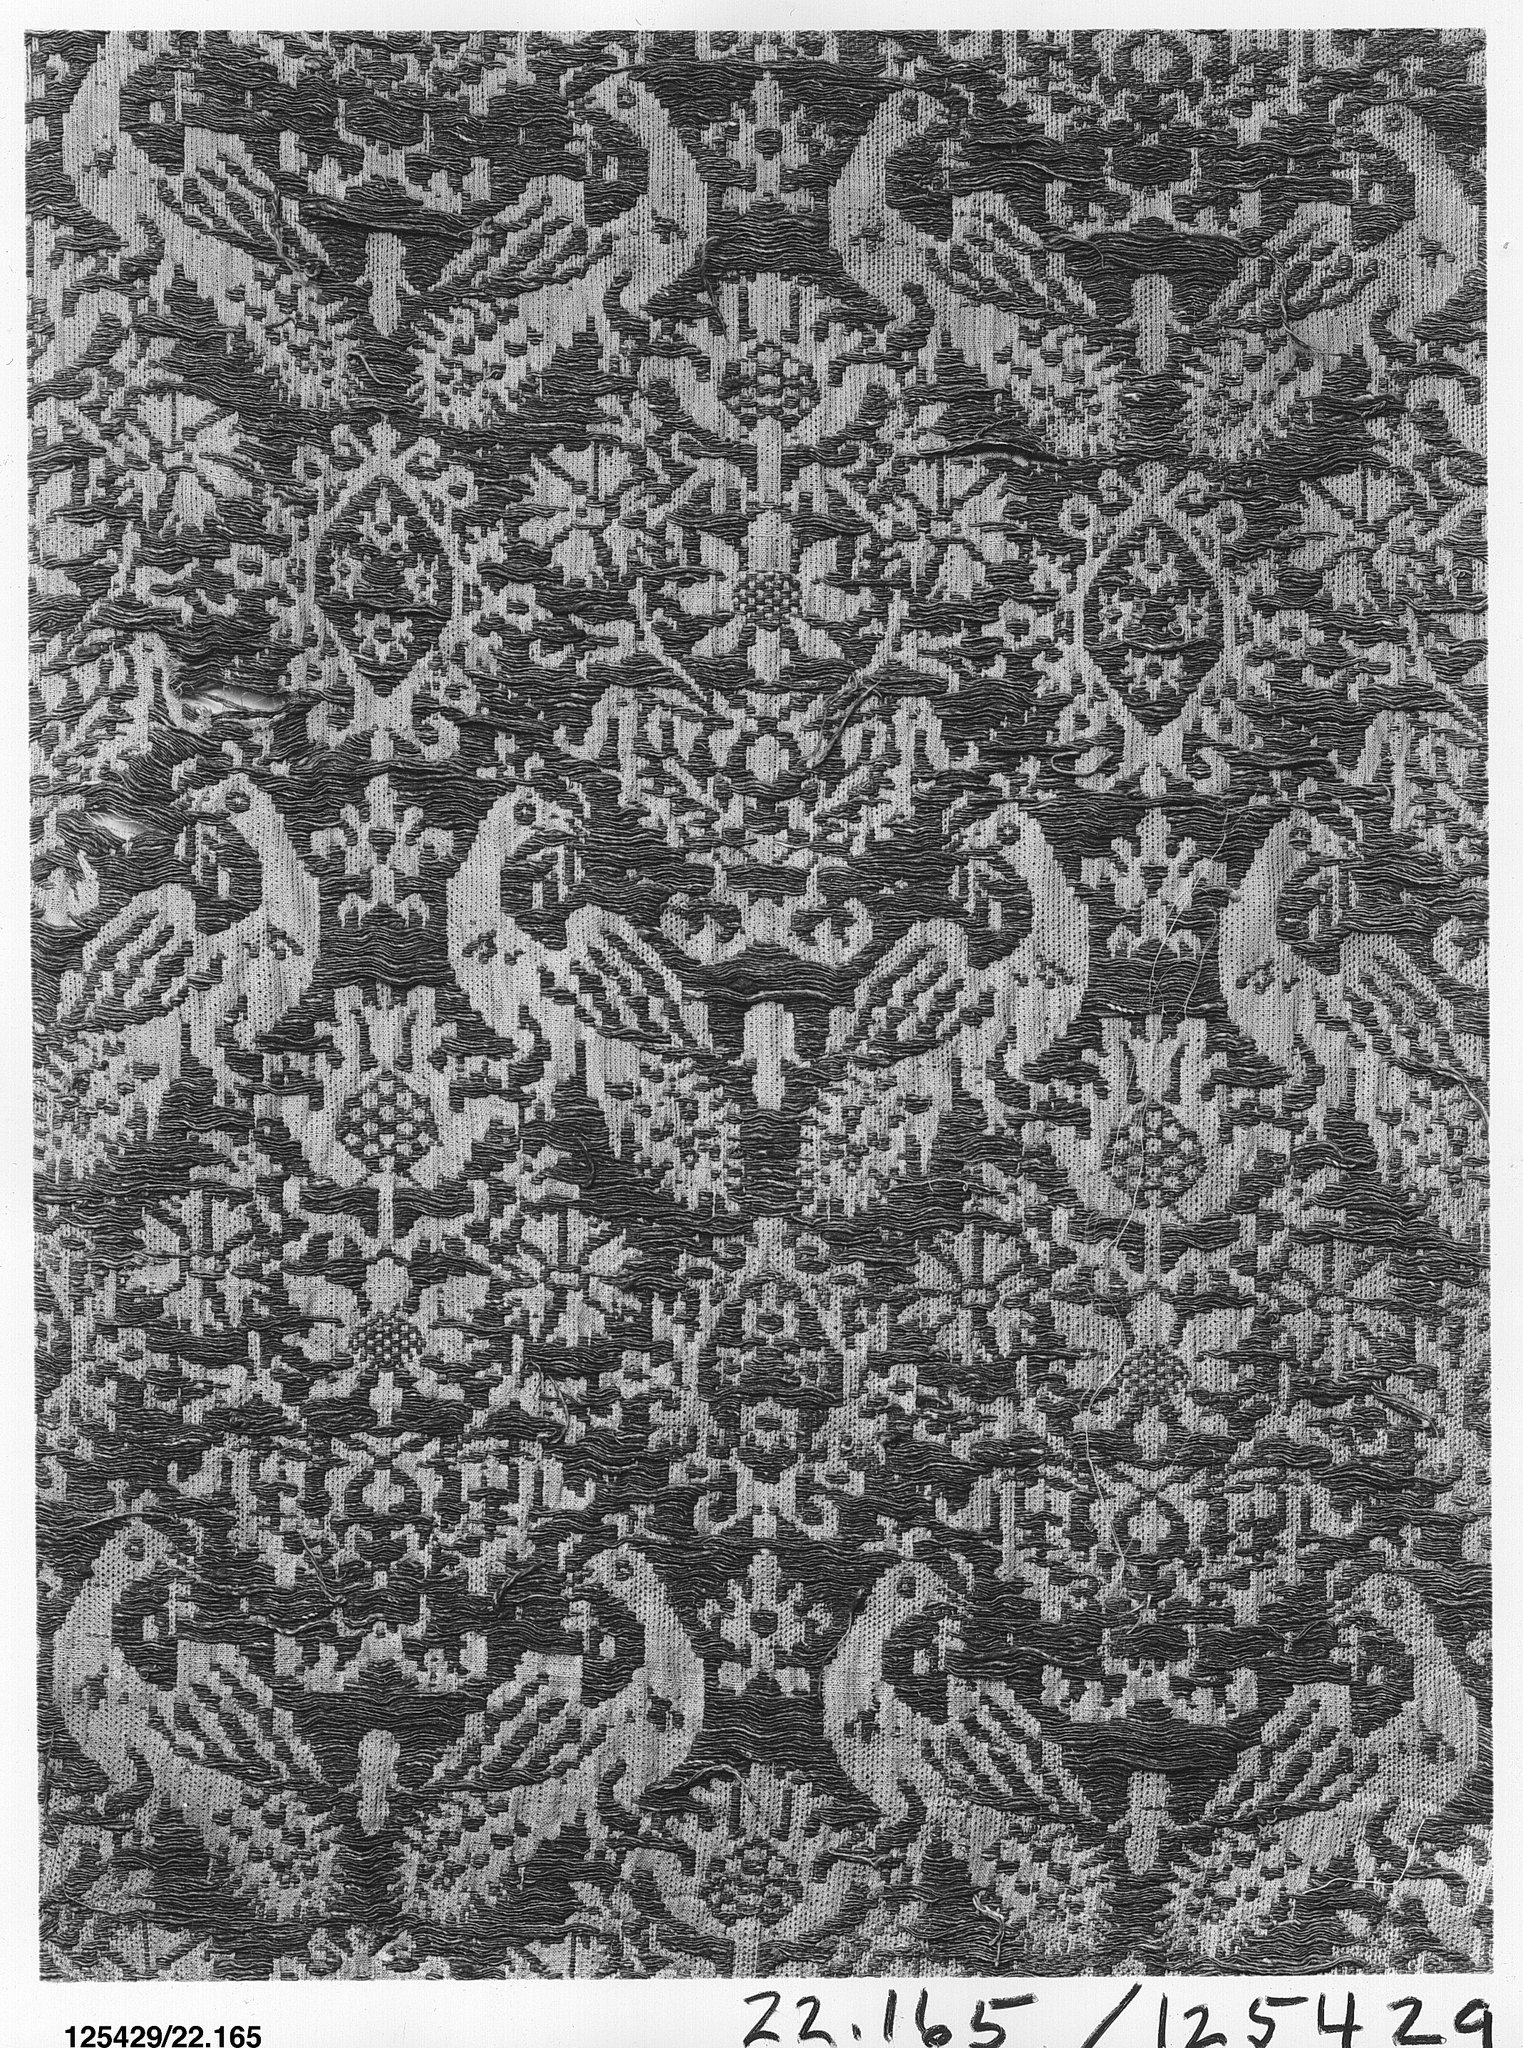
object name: piece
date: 1501-1600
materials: cotton, silk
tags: peacocks